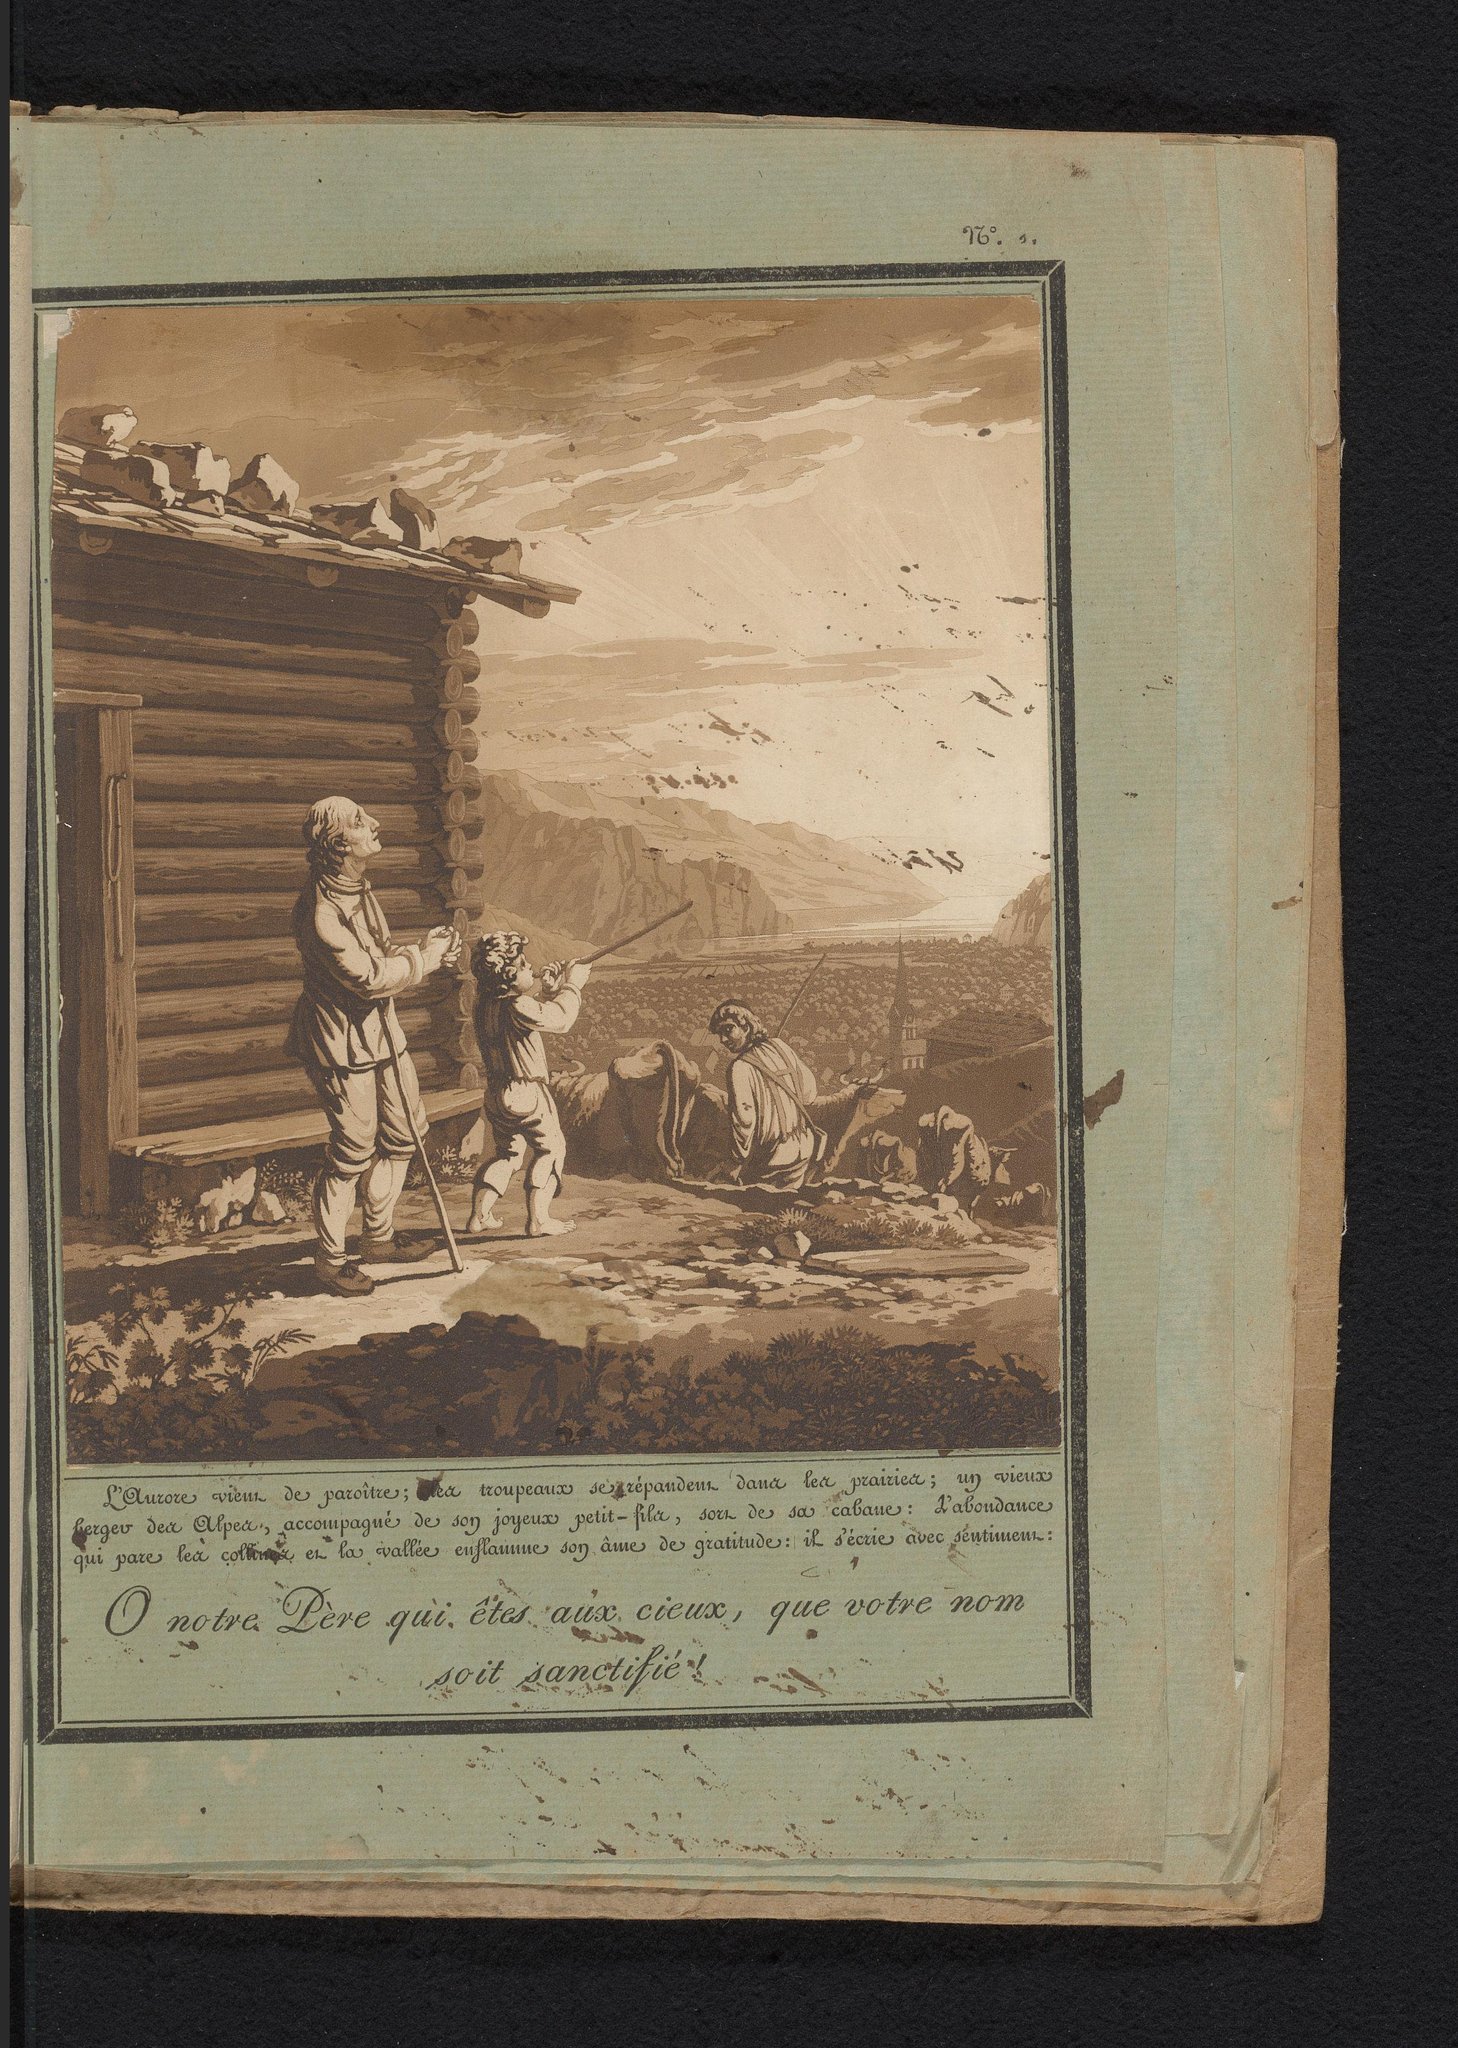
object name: album leaf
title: Oude en jonge herder aanschouwen de zonsondergang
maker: marquard wocher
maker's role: painter, print maker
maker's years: 1760-1830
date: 1803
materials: paper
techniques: aquatint, letterpress printing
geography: zurich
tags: (private) prayer; 'oratione', 'preghiere', 'preghiere a dio' (ripa), mountain meadow, alp, switzerland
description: Tekst in het Frans en nummering op het albumblad. Prent maakt deel uit van een album.